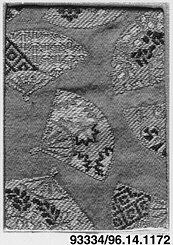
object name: piece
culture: japanese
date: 1701-1900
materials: silk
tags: fans